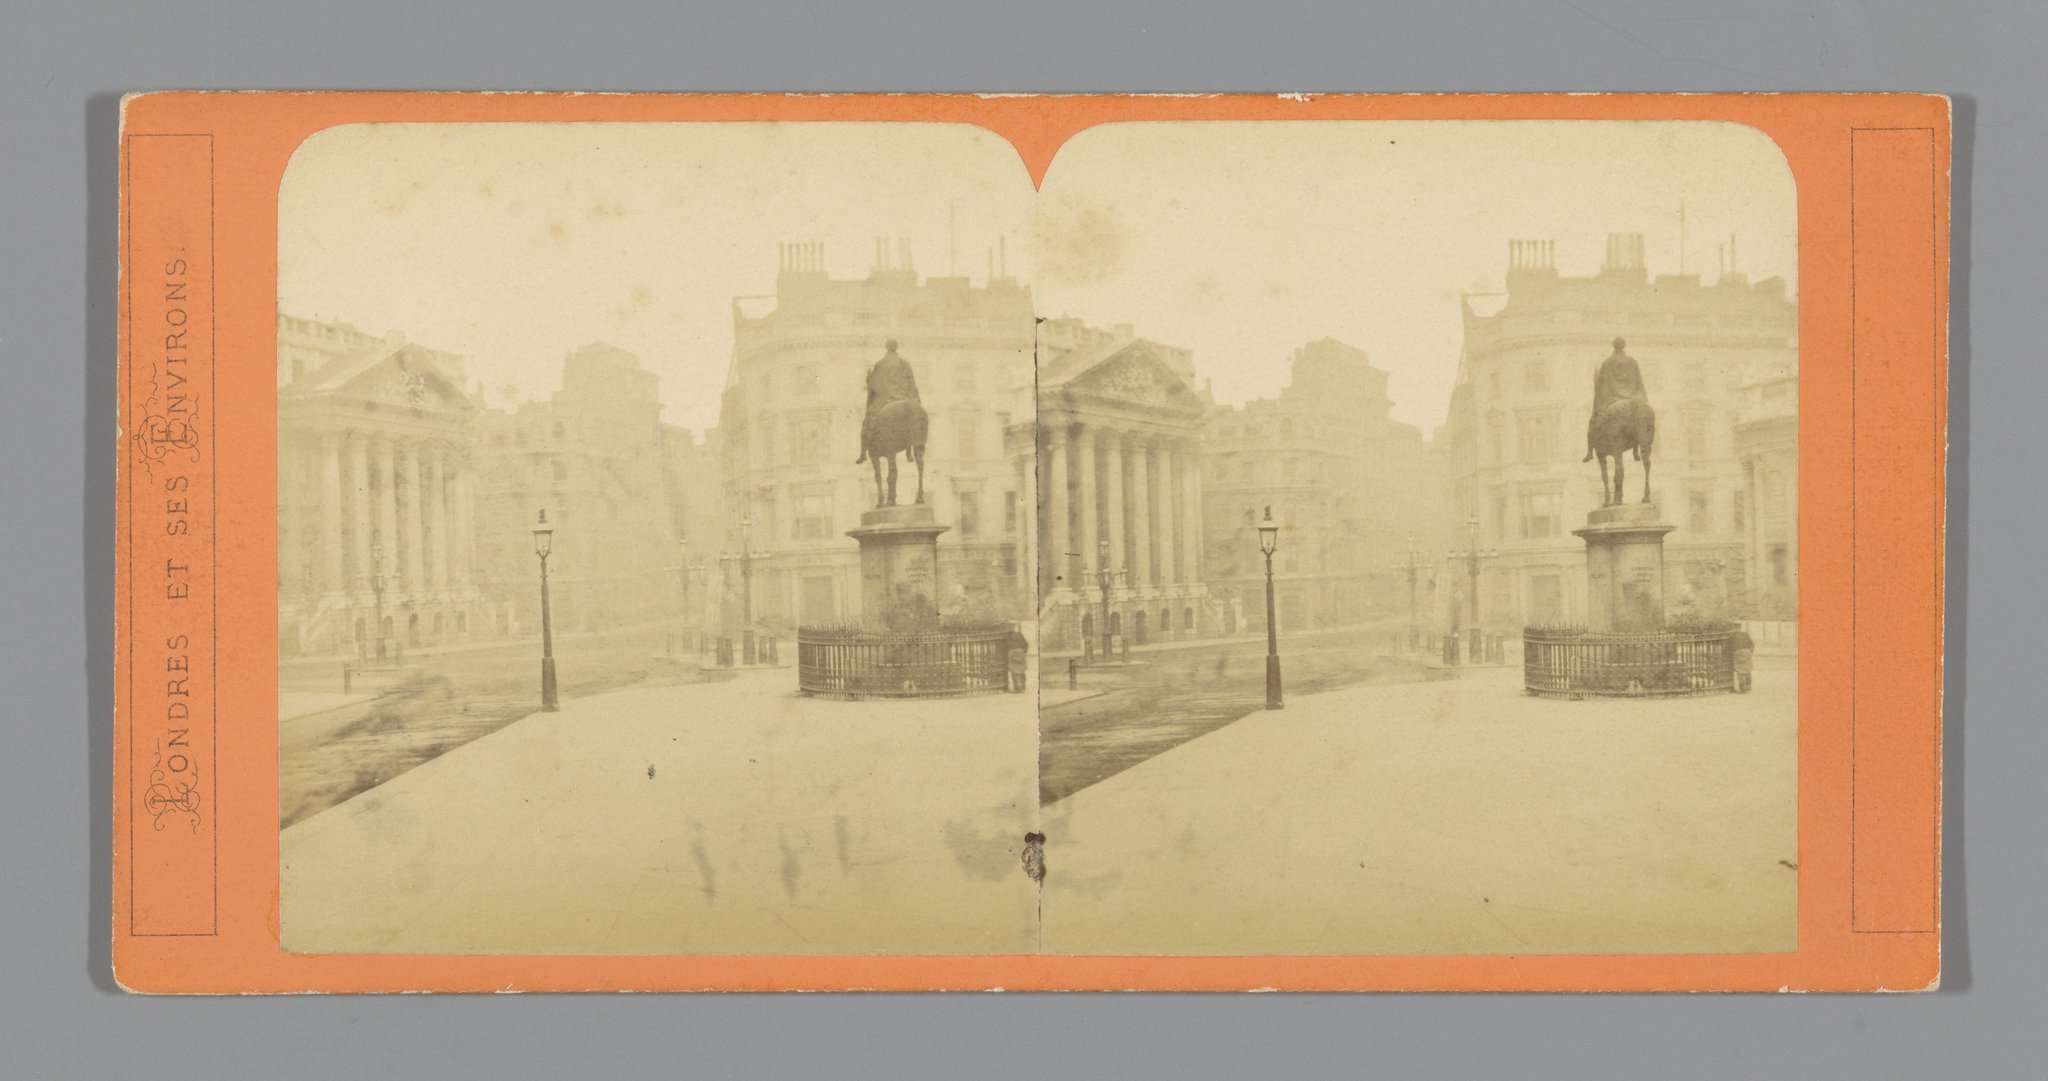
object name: stereograph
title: Gezicht op een plein met een ruiterstandbeeld in Londen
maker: Anonymous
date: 1850-1880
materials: cardboard, photographic support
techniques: albumen print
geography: london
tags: square, place, circus, etc., equestrian statue, london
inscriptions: inscription: ‘Place St. Elizabeth et Mansion House’